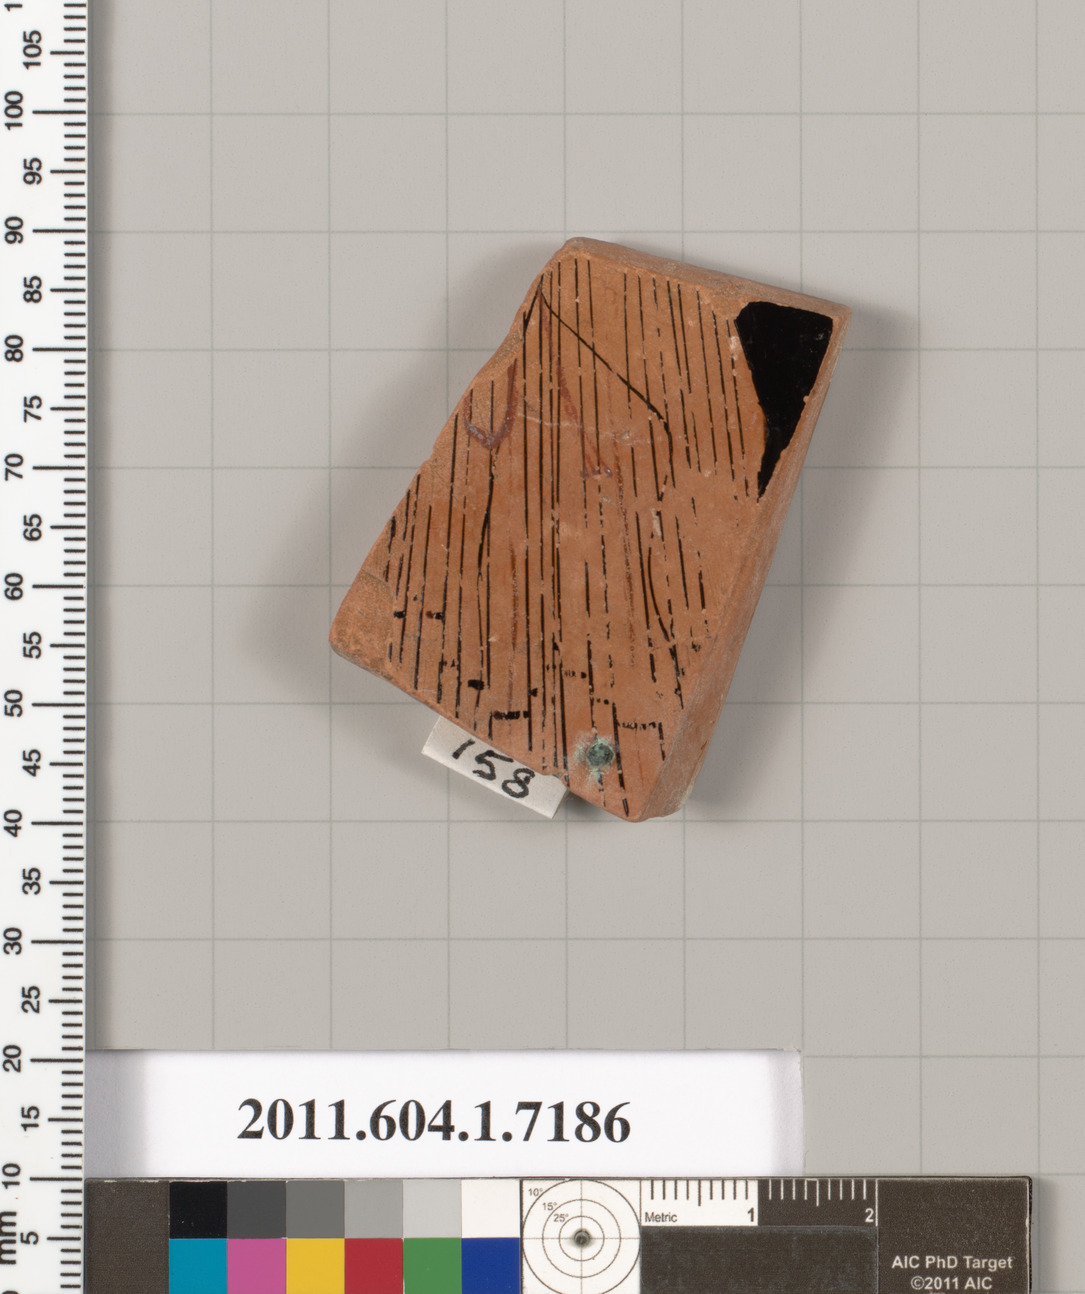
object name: kylix fragment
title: Terracotta fragment of a kylix (drinking cup)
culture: greek, attic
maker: makron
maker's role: artist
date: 500-480 BCE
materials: terracotta